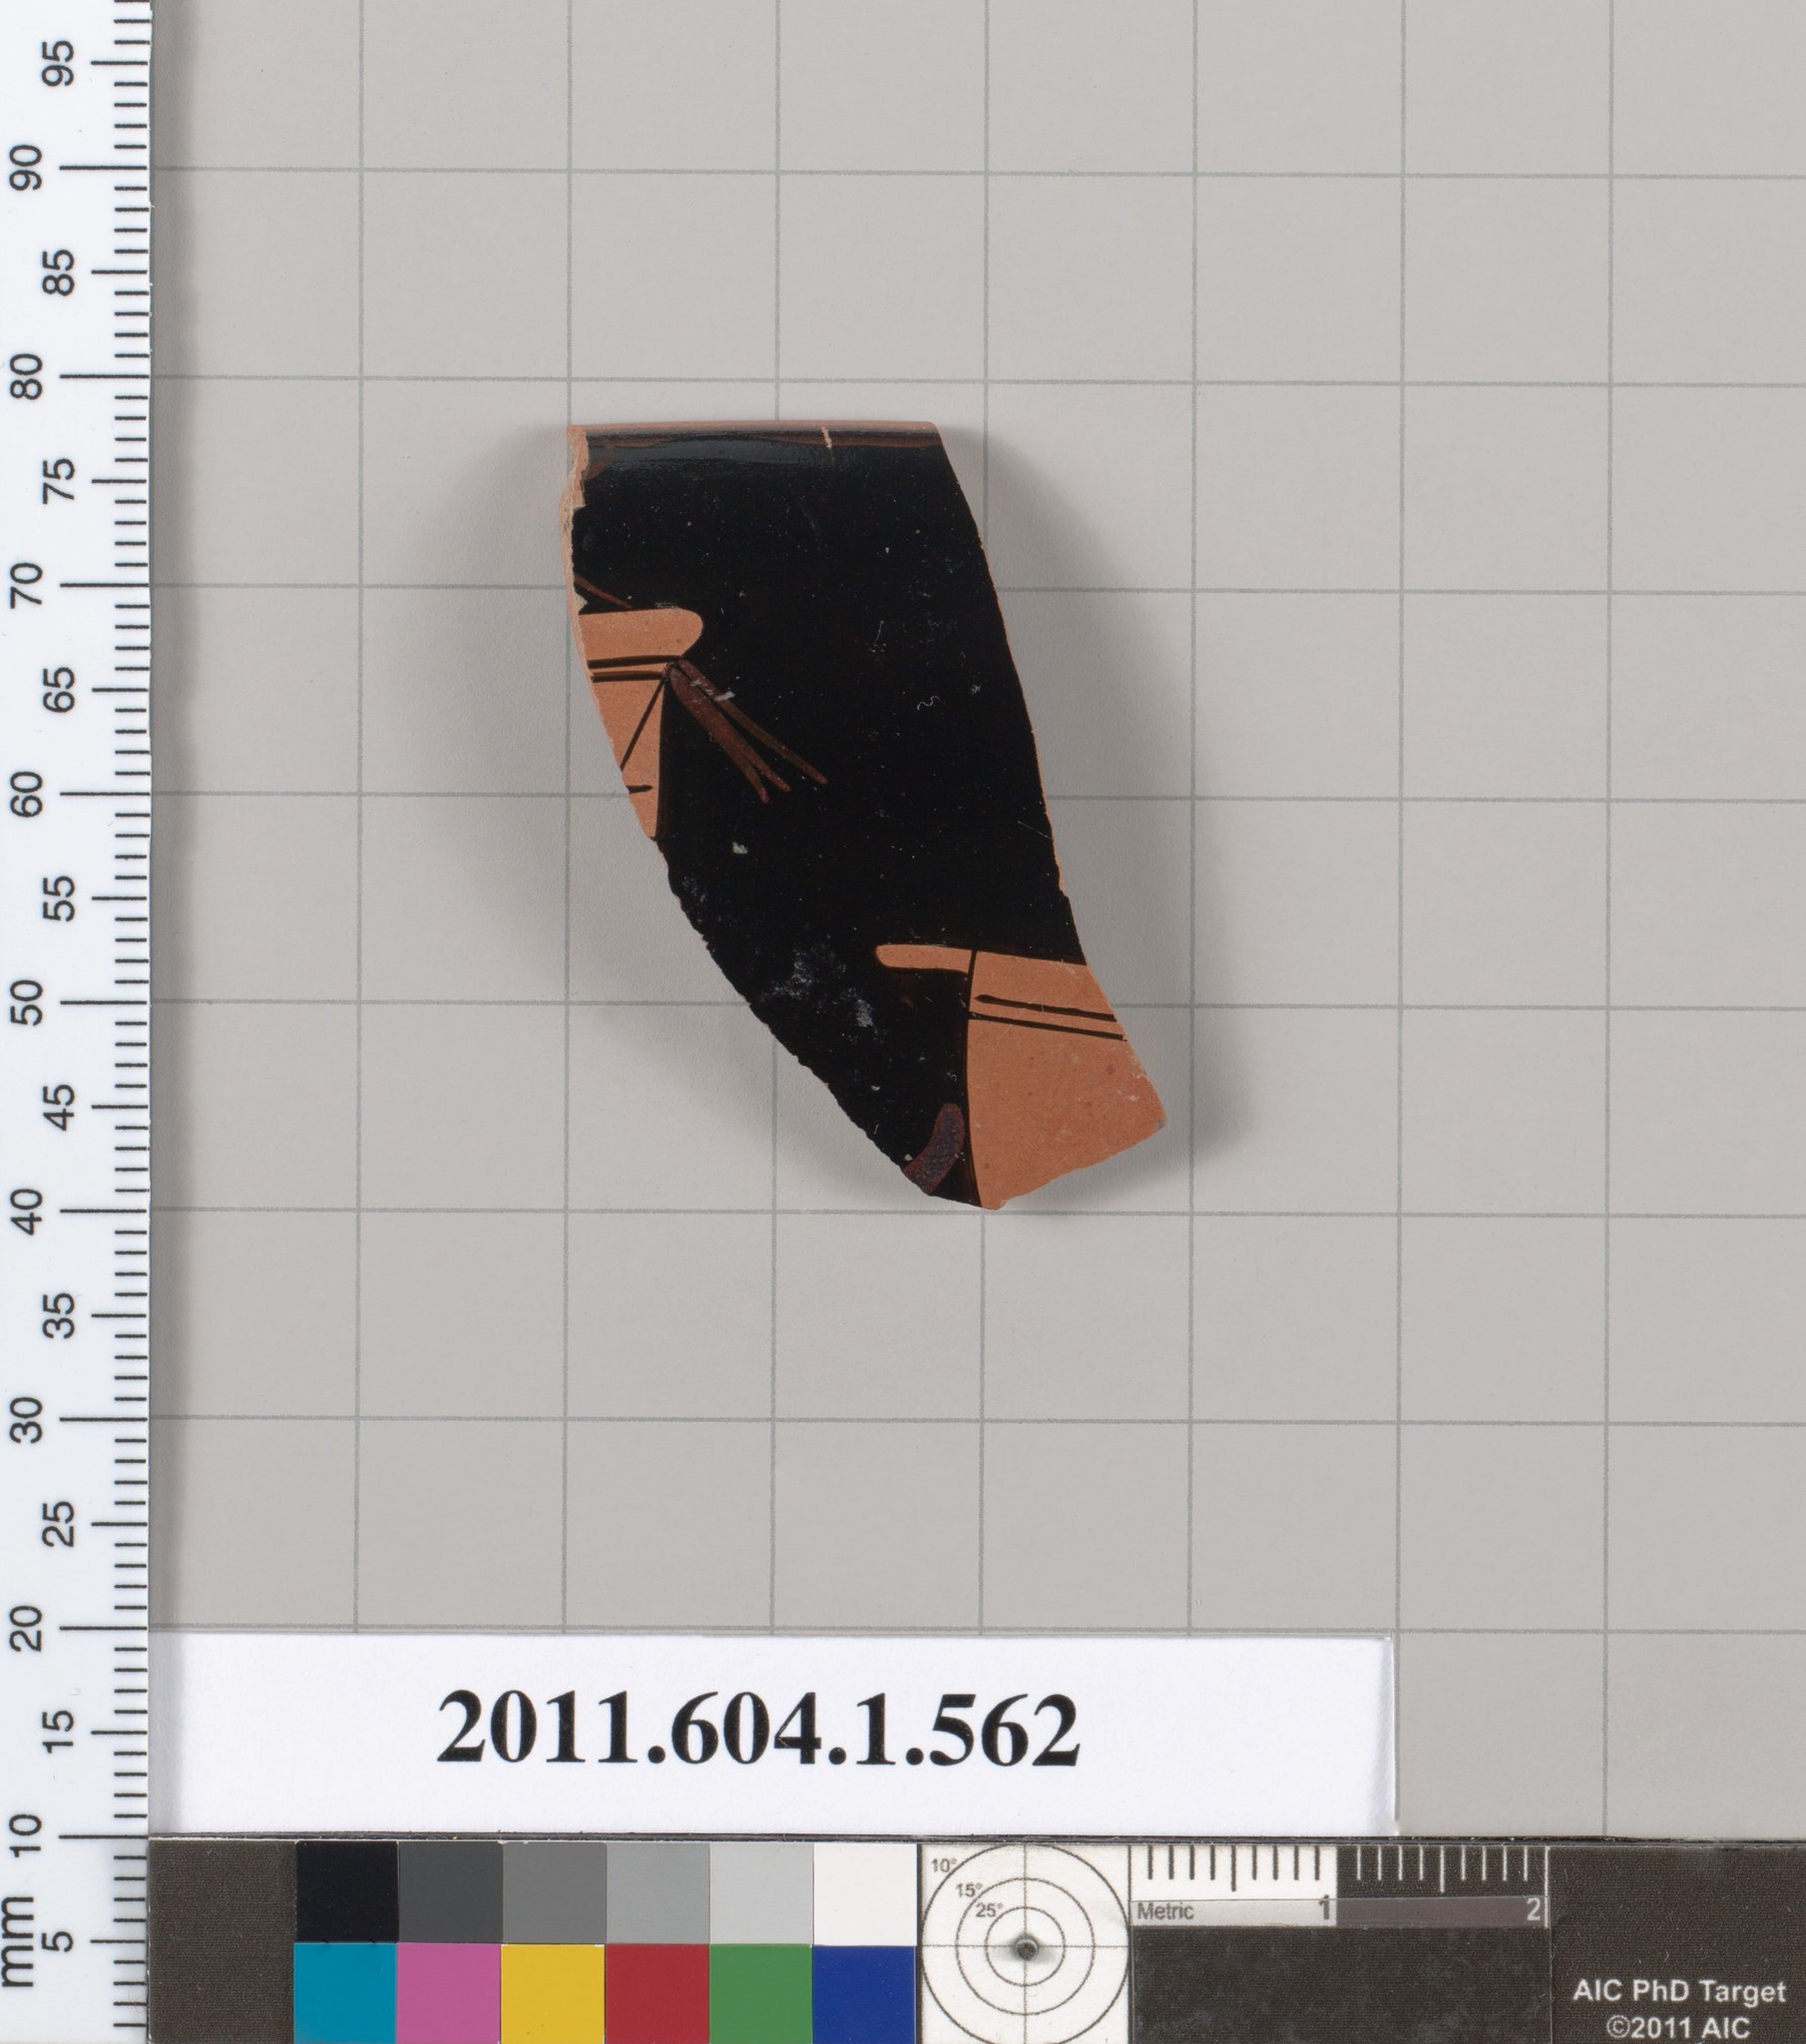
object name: kylix fragment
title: Terracotta rim fragment of a kylix (drinking cup)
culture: greek, attic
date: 480-470 BCE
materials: terracotta